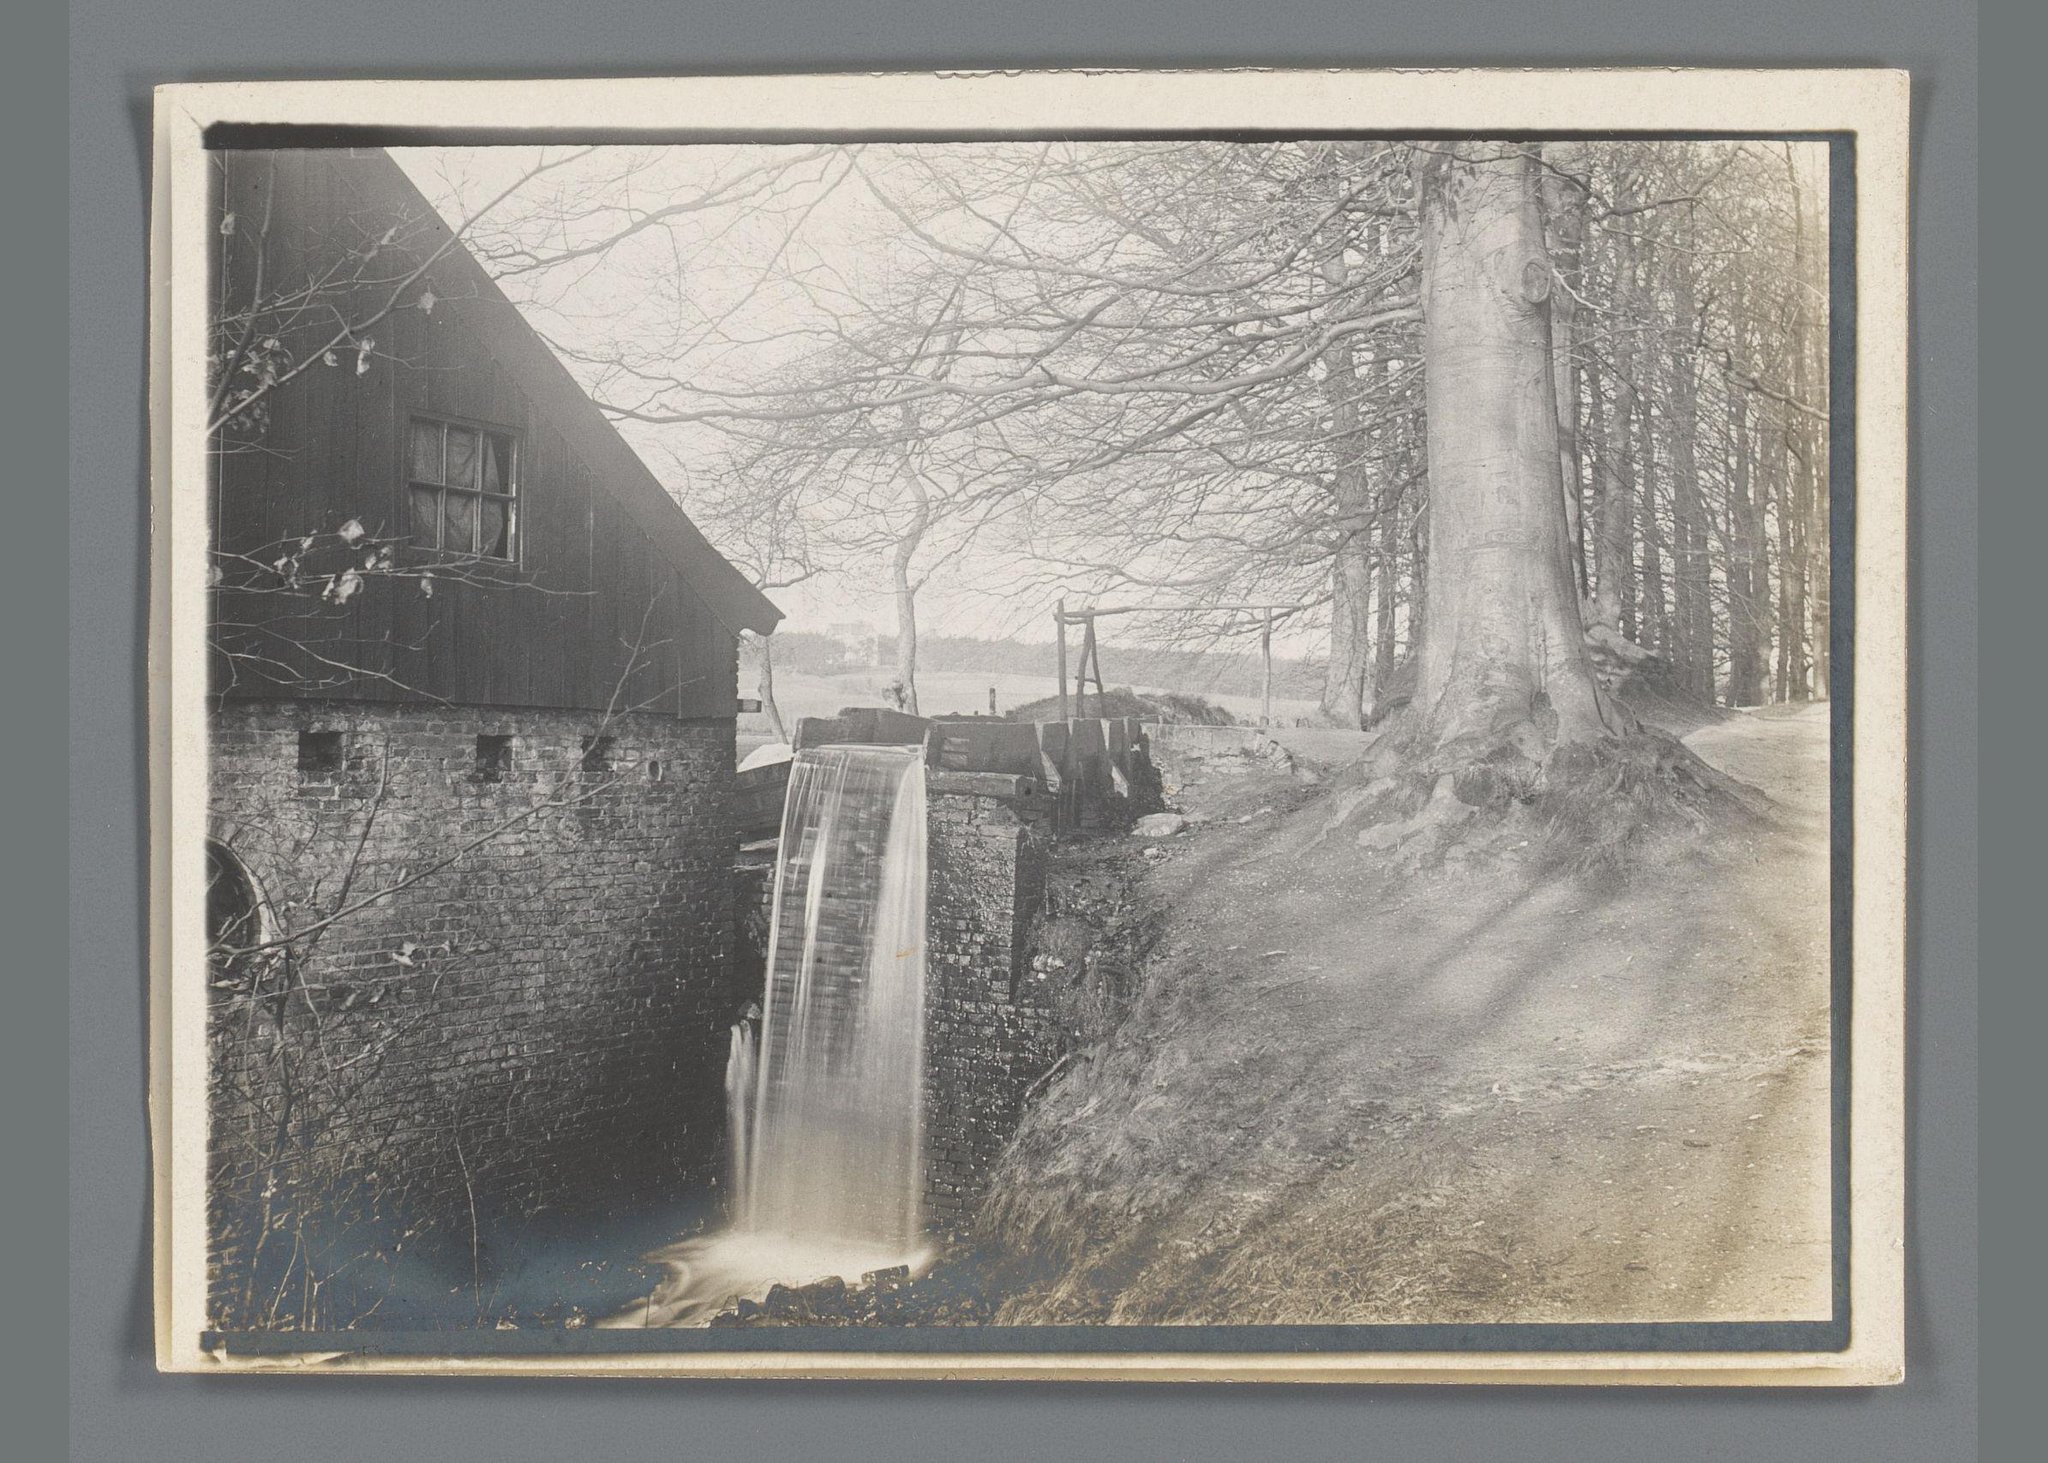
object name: photograph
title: Boerderij met watermolen in Limburg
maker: willem de jong (fotograaf)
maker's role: arts, fotograaf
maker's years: 1864-1918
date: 1895-1918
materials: paper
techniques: gelatin silver print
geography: limburg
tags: forest, wood, watermill, farm (building)